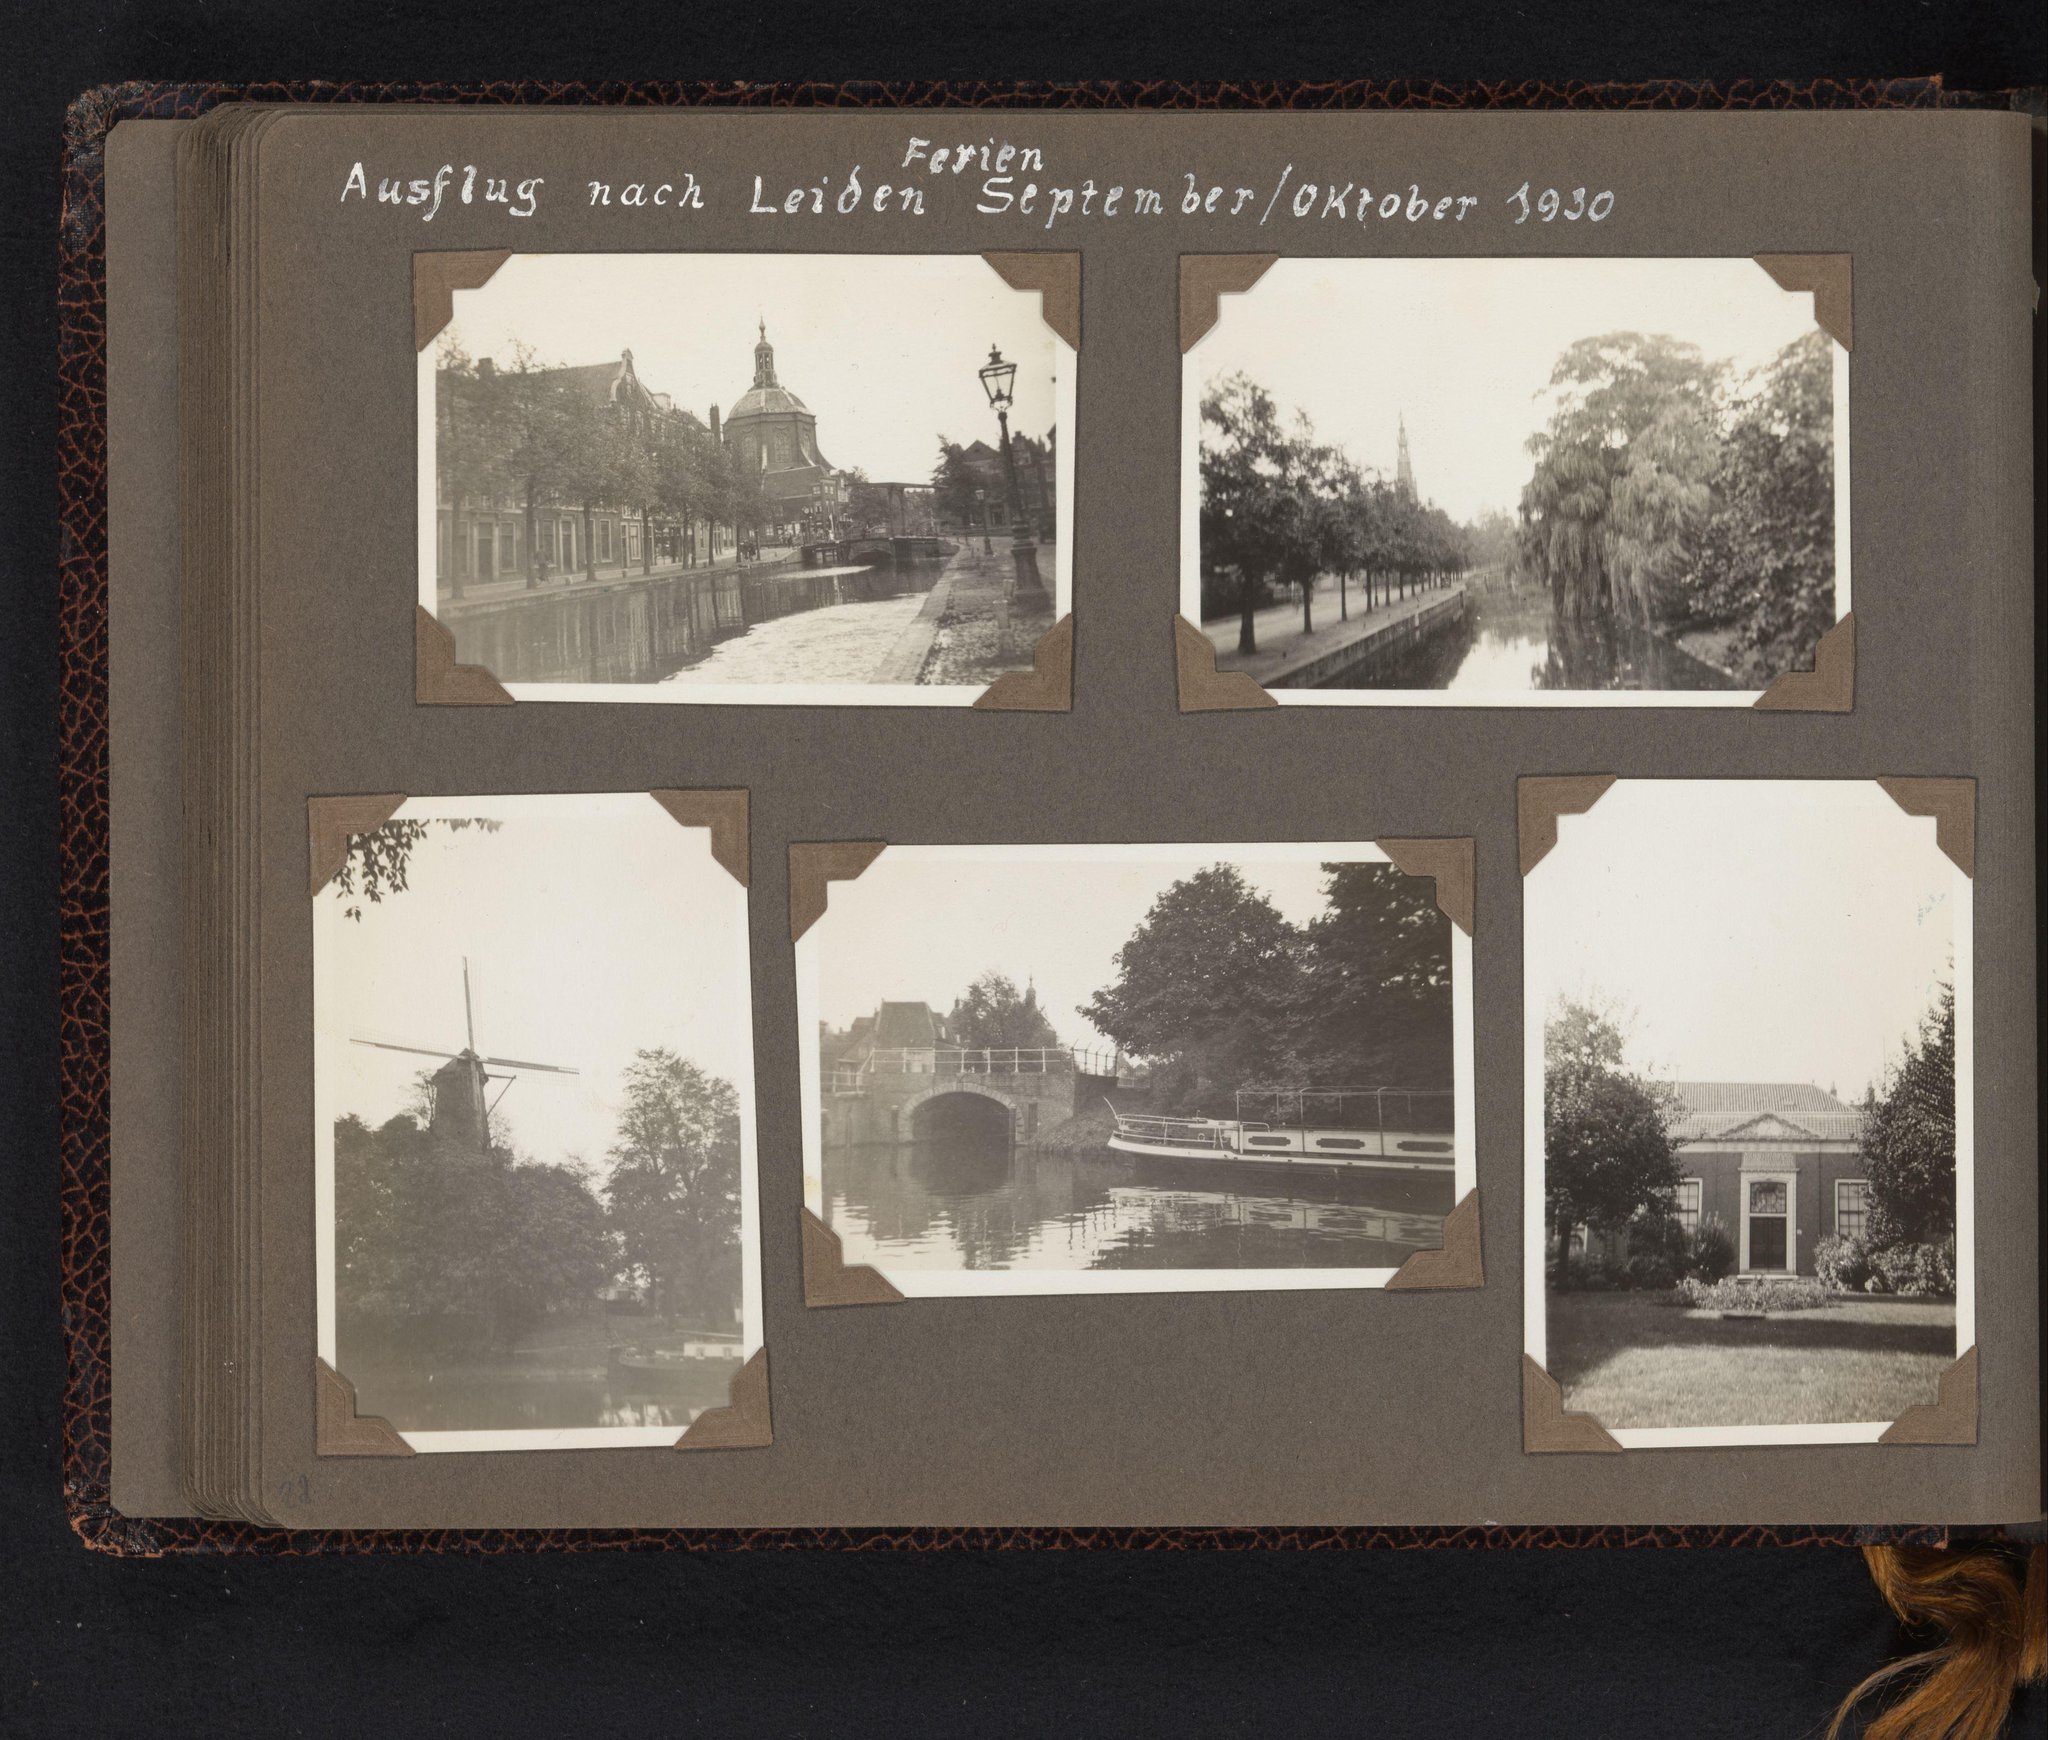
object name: photograph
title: Bezoek aan Leiden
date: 1930-1931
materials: cardboard, paper, photographic support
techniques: gelatin silver print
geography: leiden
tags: canals, waters (in city), leiden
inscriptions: annotation: ‘Ferien/ Ausflug nach Leiden September/Oktober 1930’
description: Vijf foto's van bezienswaardigheden te Leiden, waaronder de Marekerk. Deze pagina maakt deel uit van een album.